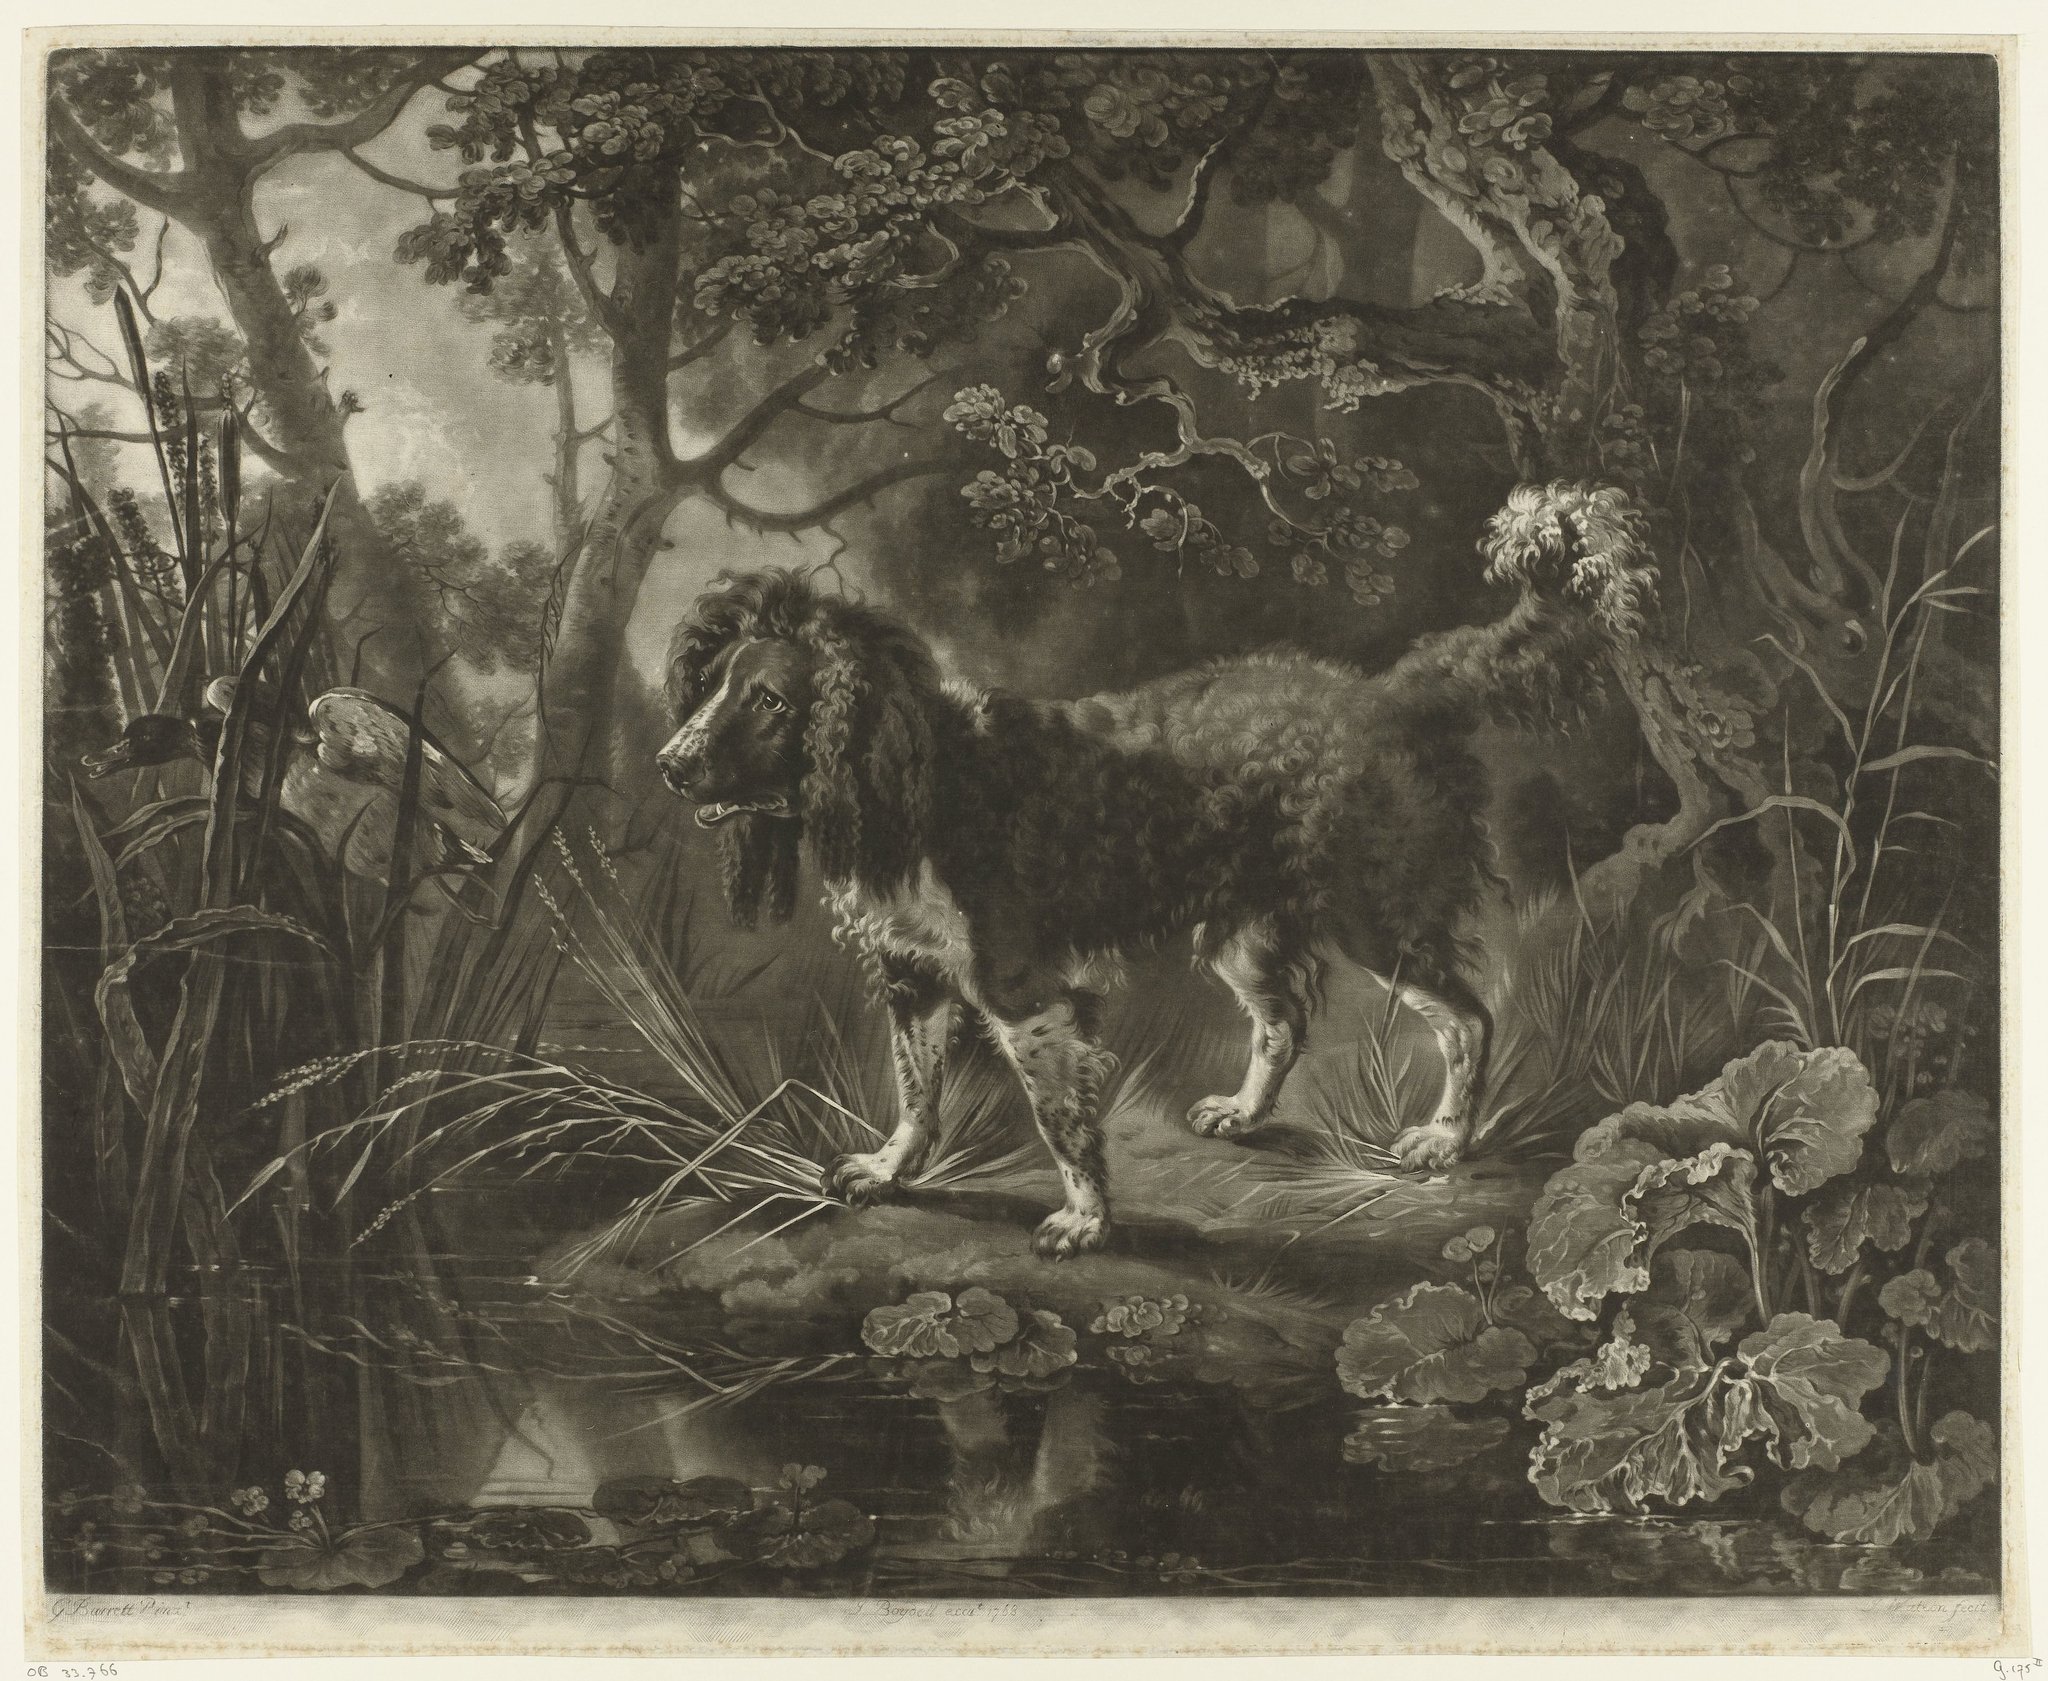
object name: print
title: Spaniël bij de waterkant kijkt naar wegvliegende eend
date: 1768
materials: paper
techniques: mezzotint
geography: london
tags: hunting dogs, water-birds: duck, dog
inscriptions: collector's mark: Lugt 240